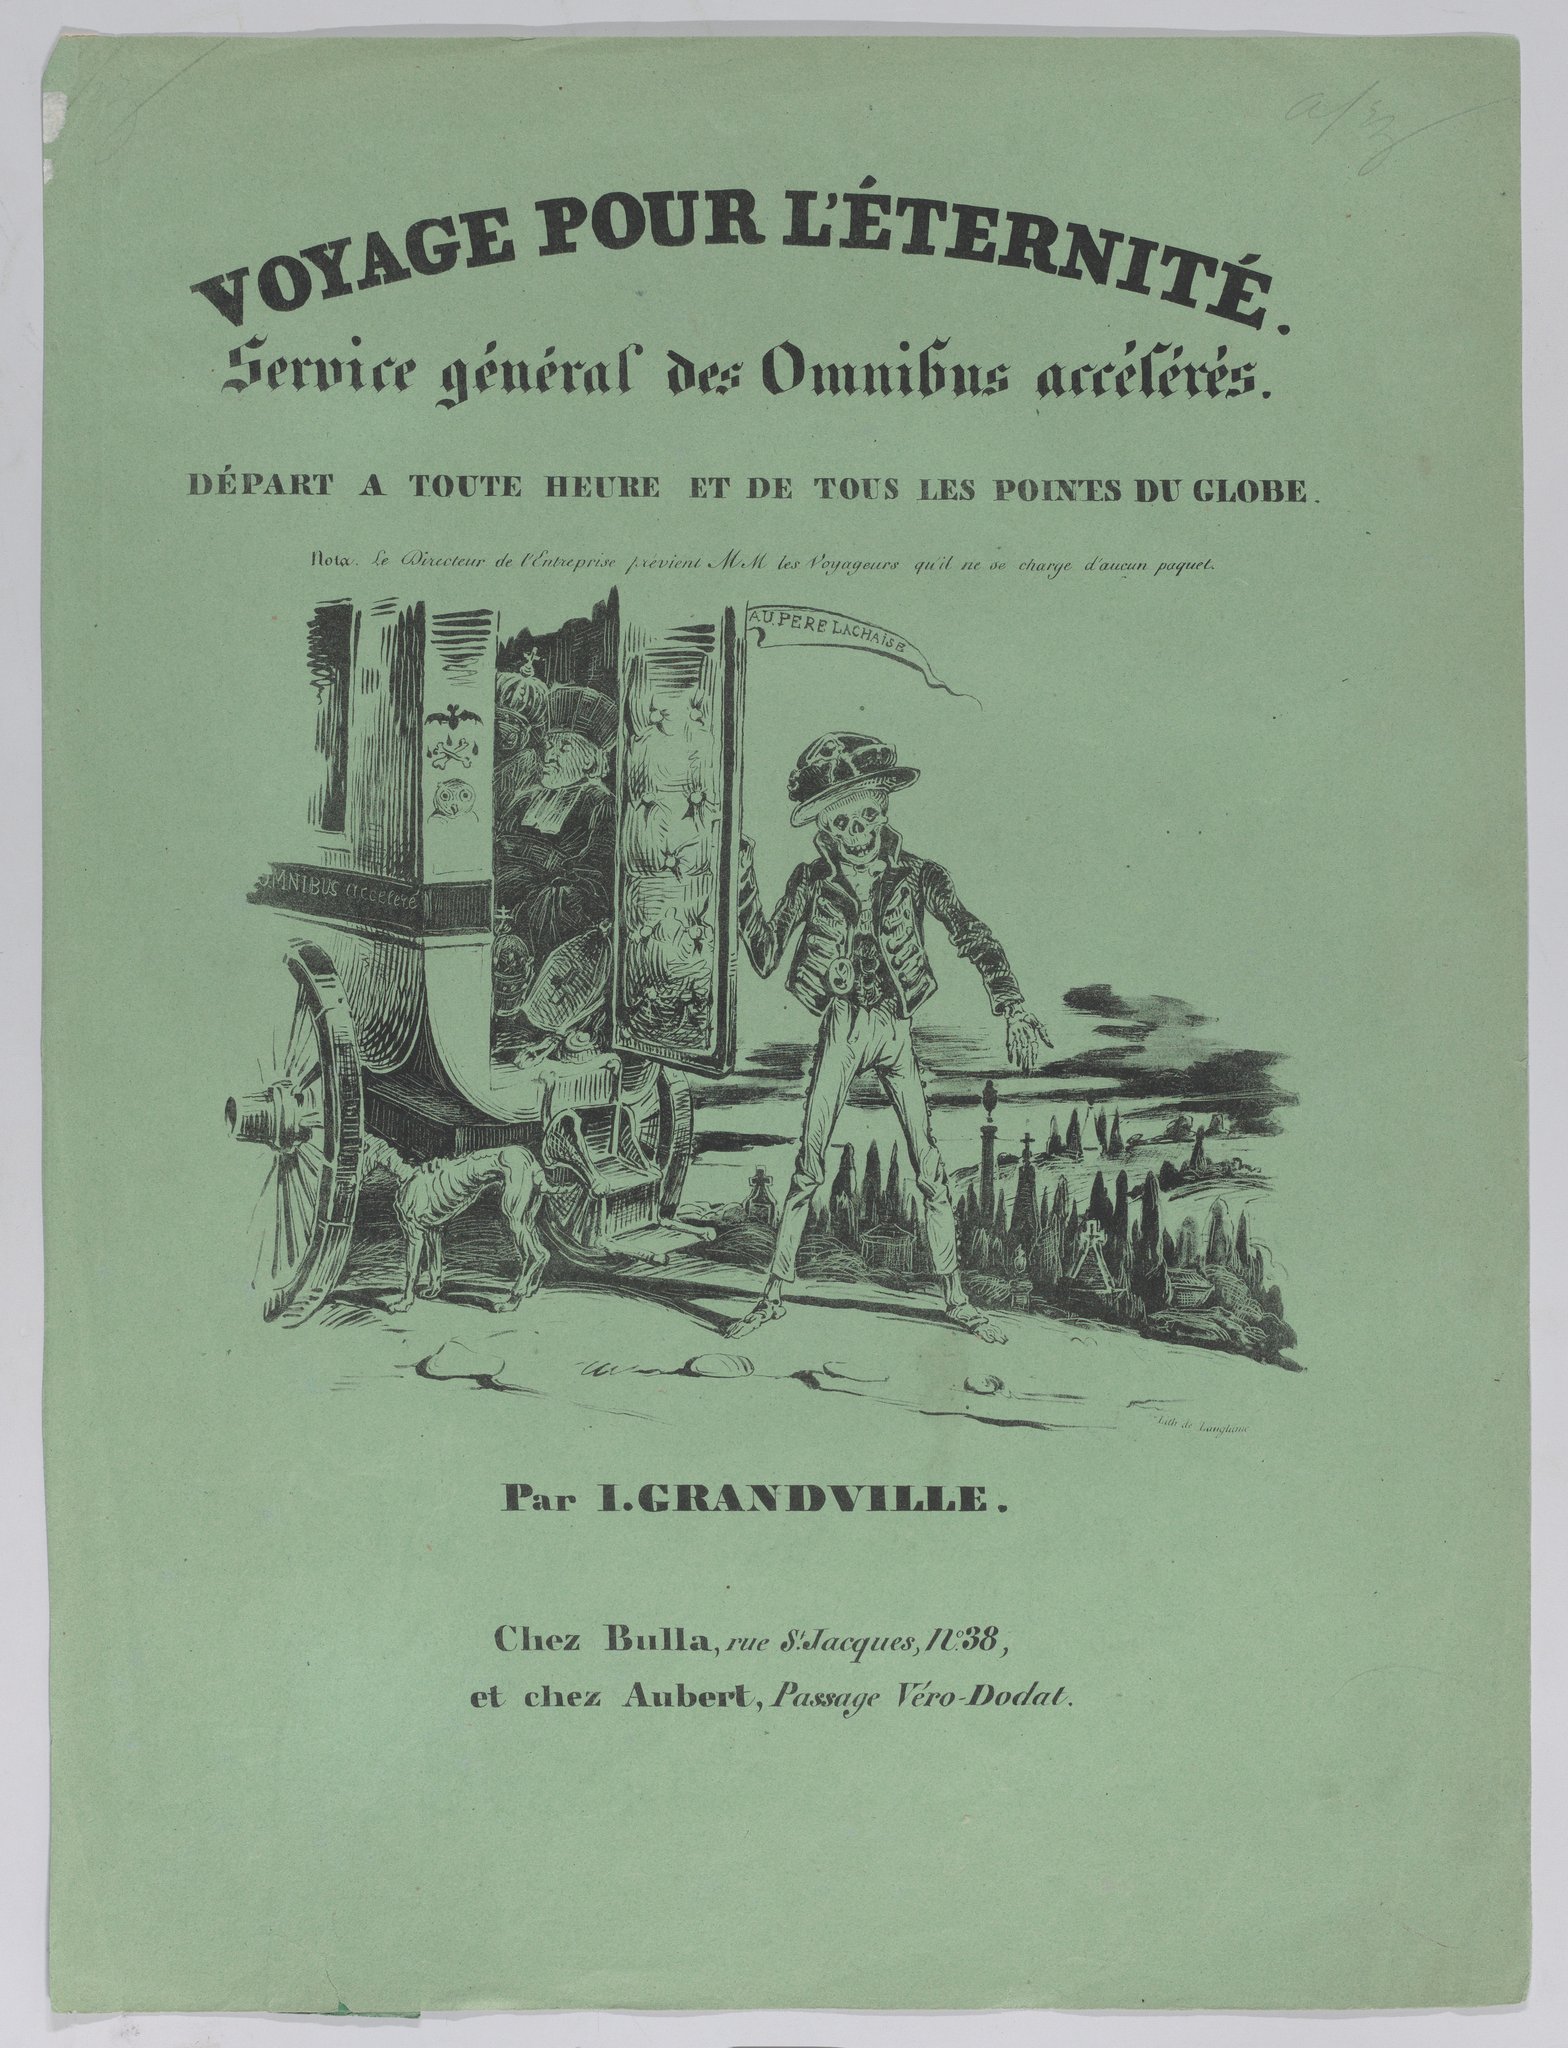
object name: print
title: Journey for Eternity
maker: j. j. grandville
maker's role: artist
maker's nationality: french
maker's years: 1803-1847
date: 1830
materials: paper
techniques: lithograph